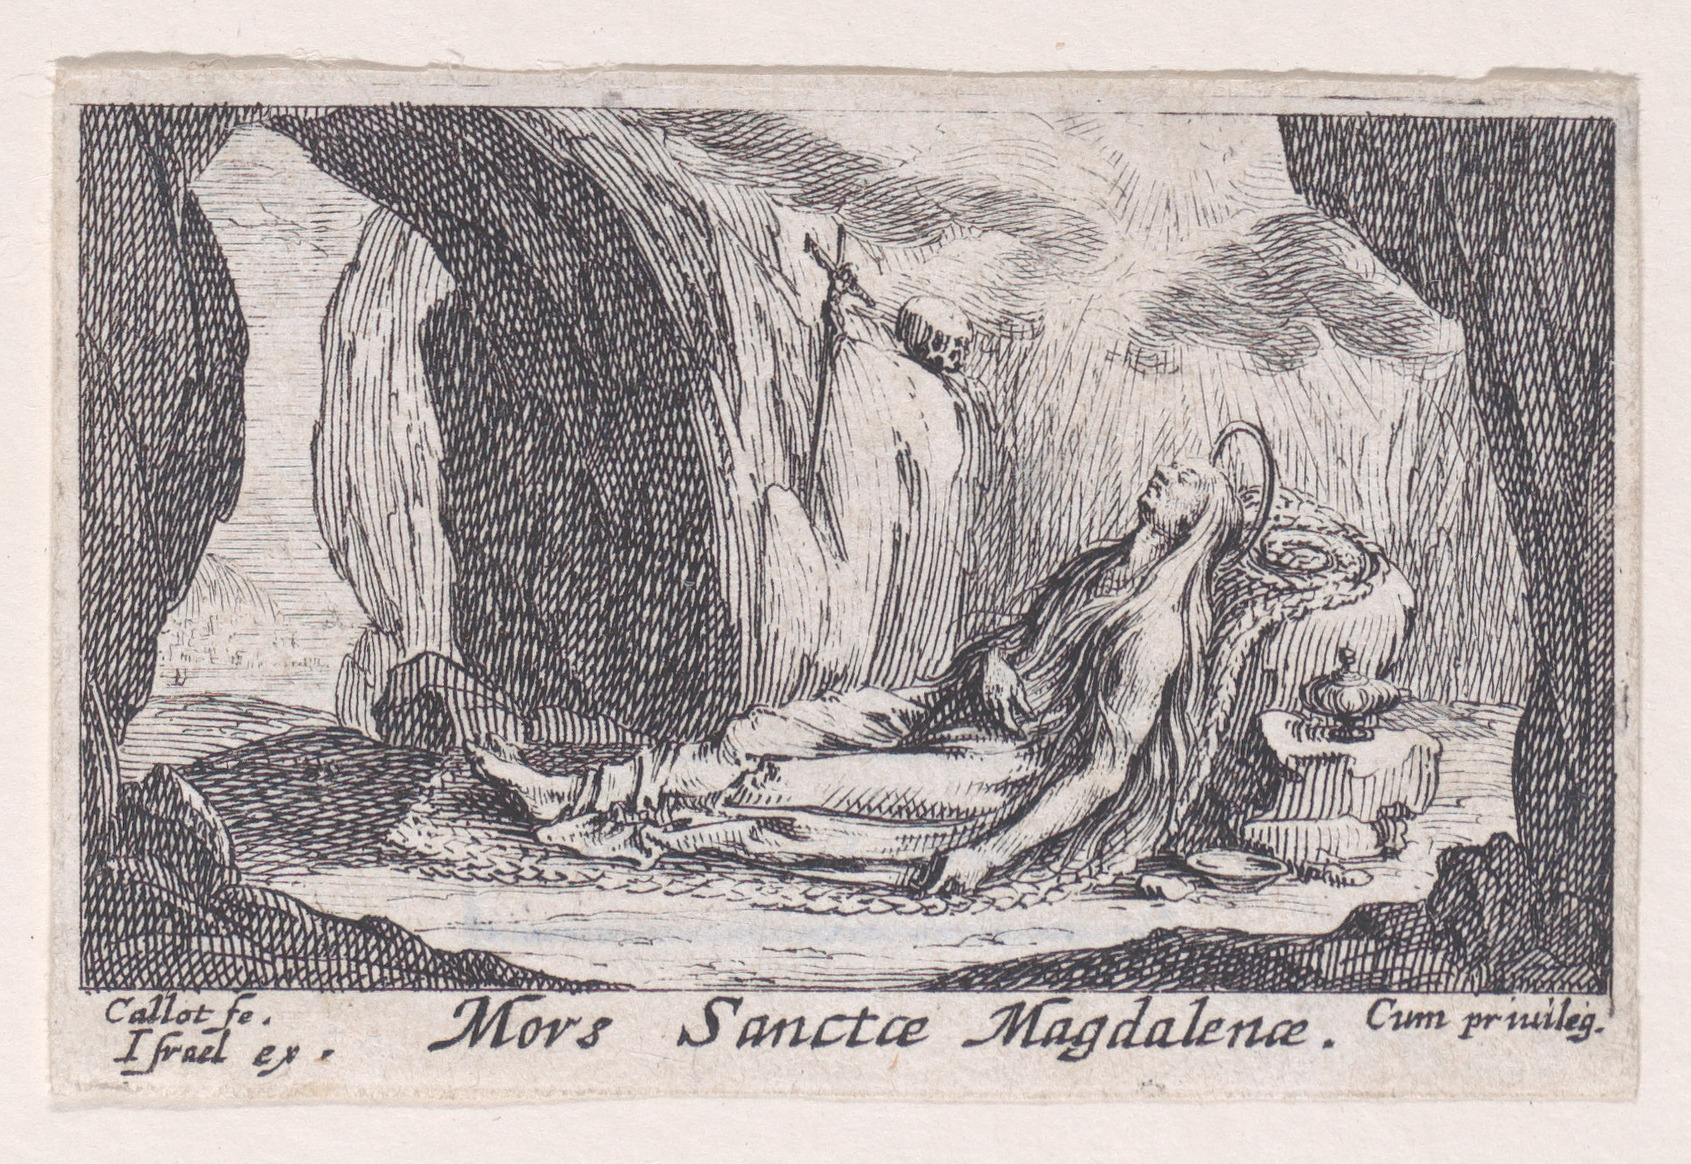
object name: print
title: The Death of St. Mary Magdalen, from "Les Pénitents et Pénitentes" (The Penitents)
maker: jacques callot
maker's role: artist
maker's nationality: french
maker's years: 1592-1635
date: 1632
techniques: etching